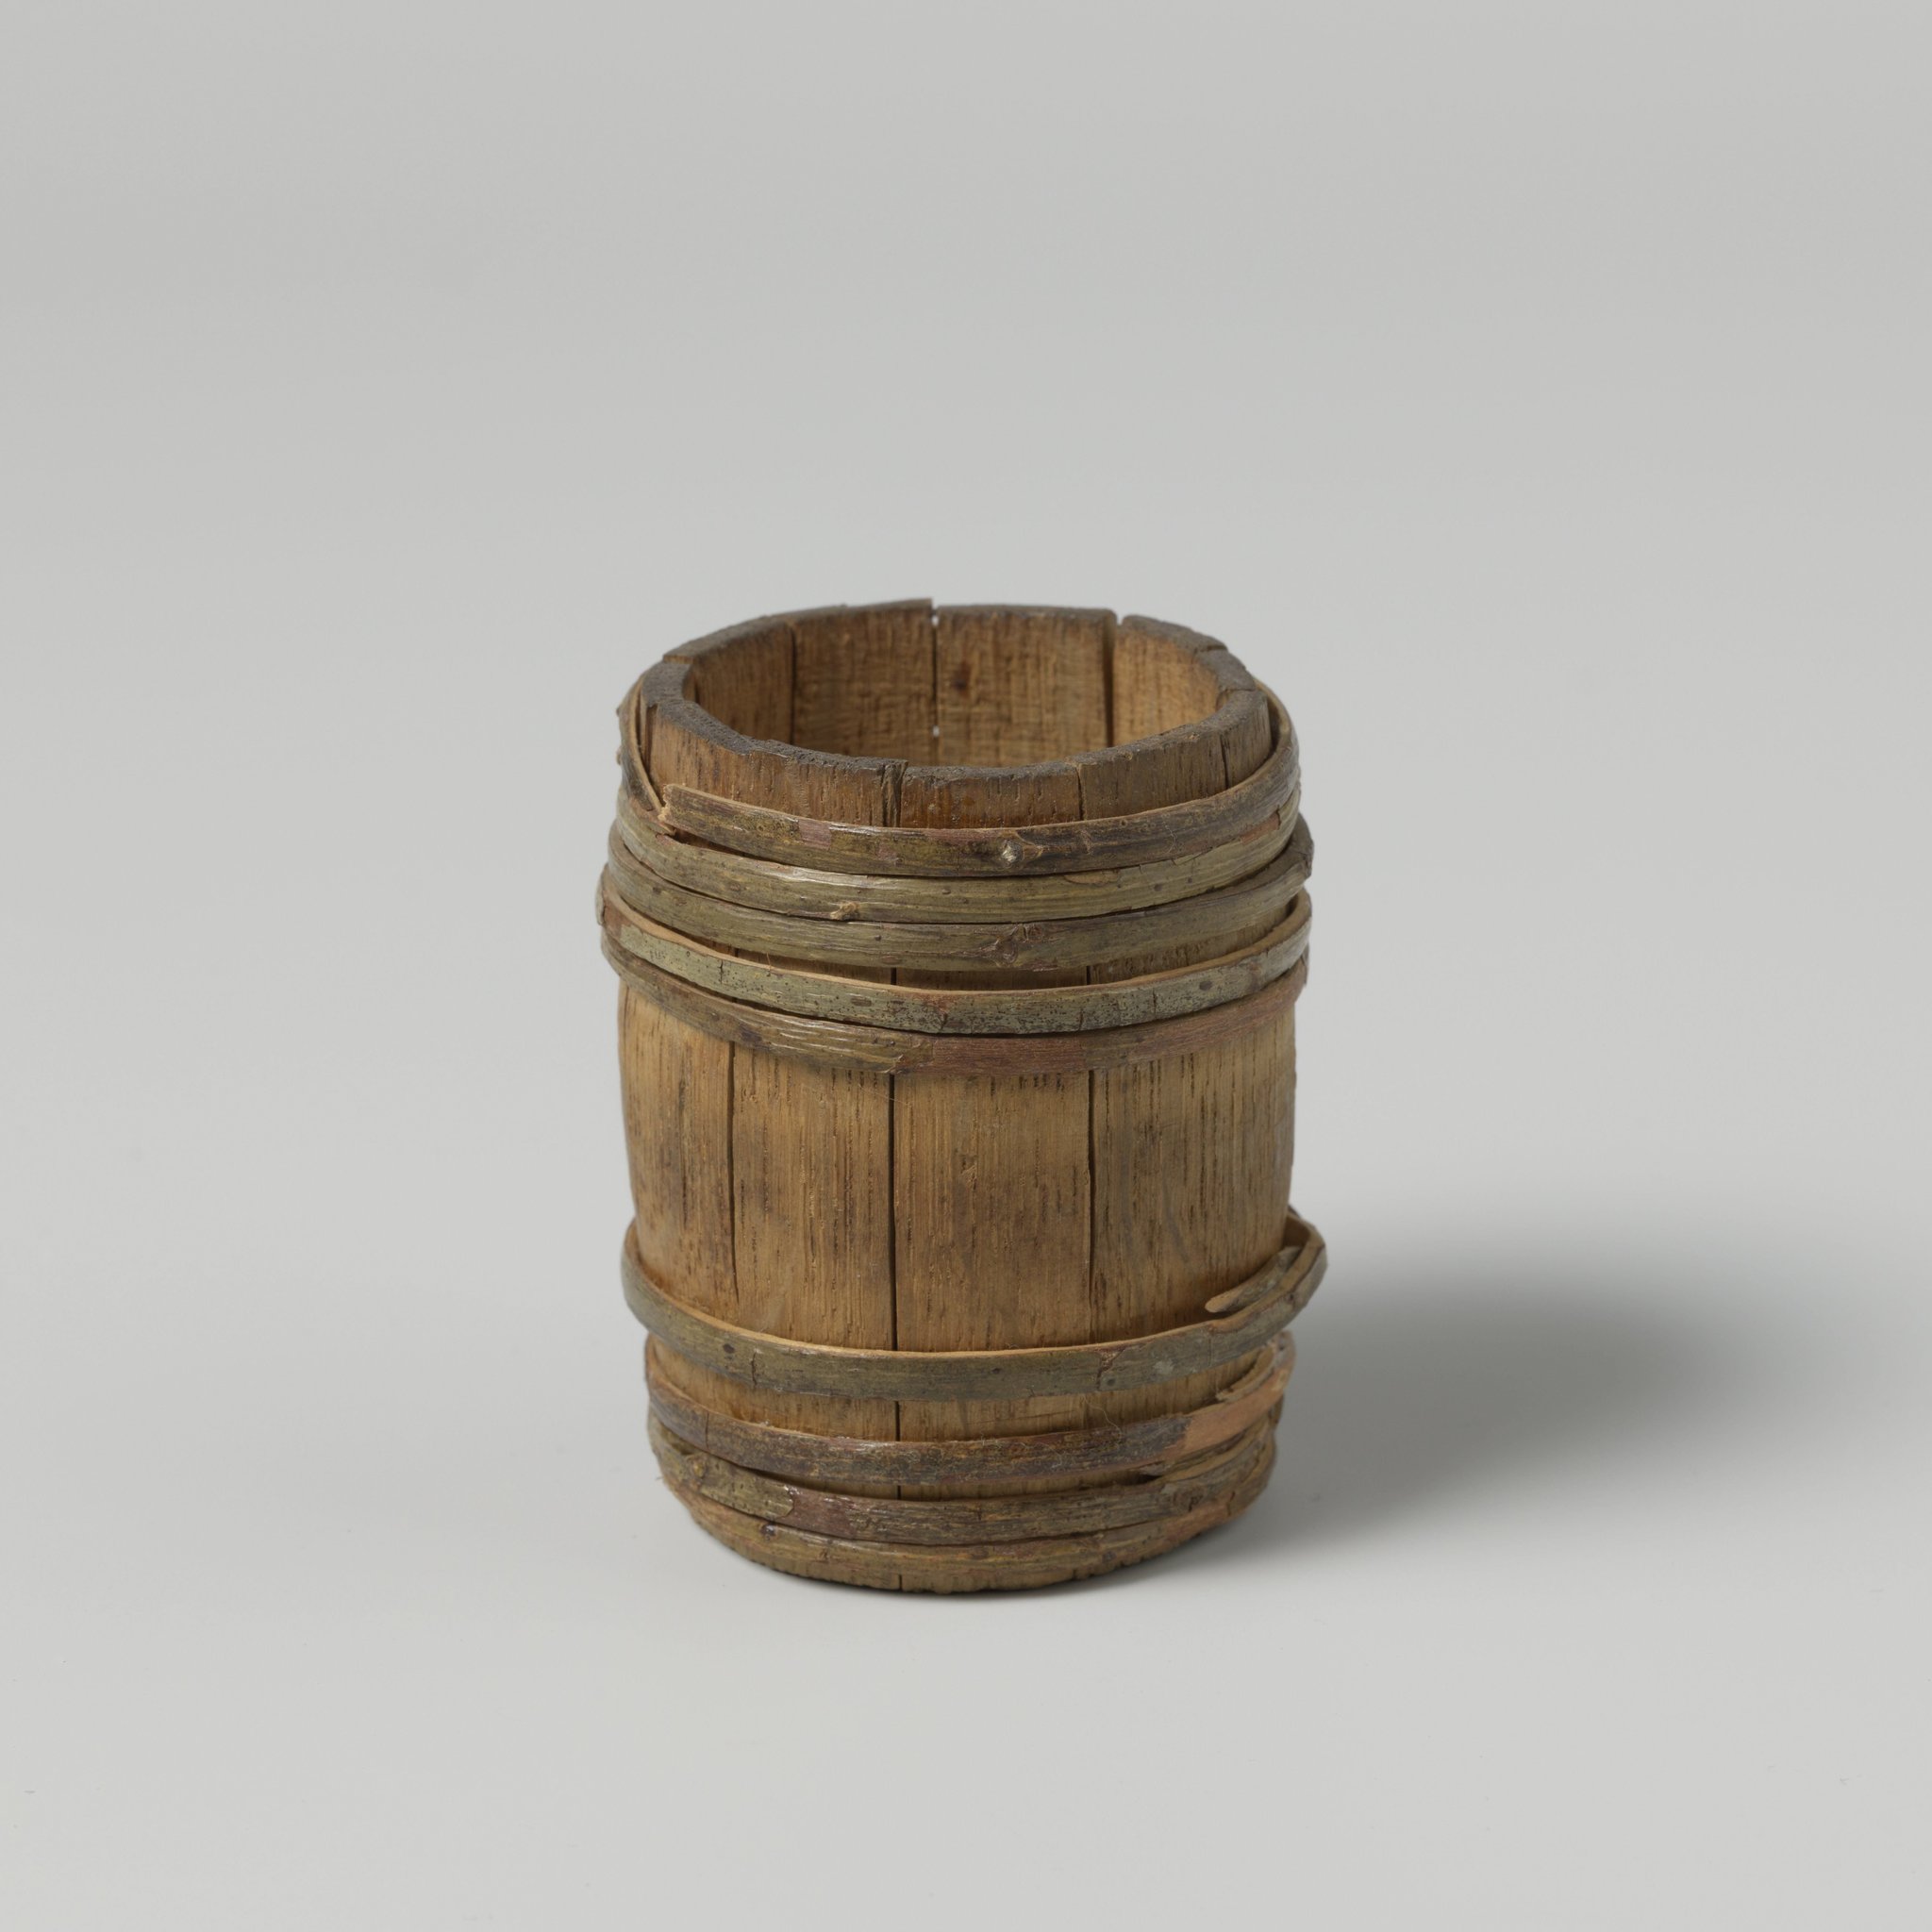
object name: tun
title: Ton, vervaardigd uit duigen omwonden met negen en zes hoepels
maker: Anonymous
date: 1700-1799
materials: wood, plant material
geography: amsterdam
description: Een ton gemaakt van losse eikenhouten duigen omwonden met negen en zes hoepels van ongescholde wilgenteen.